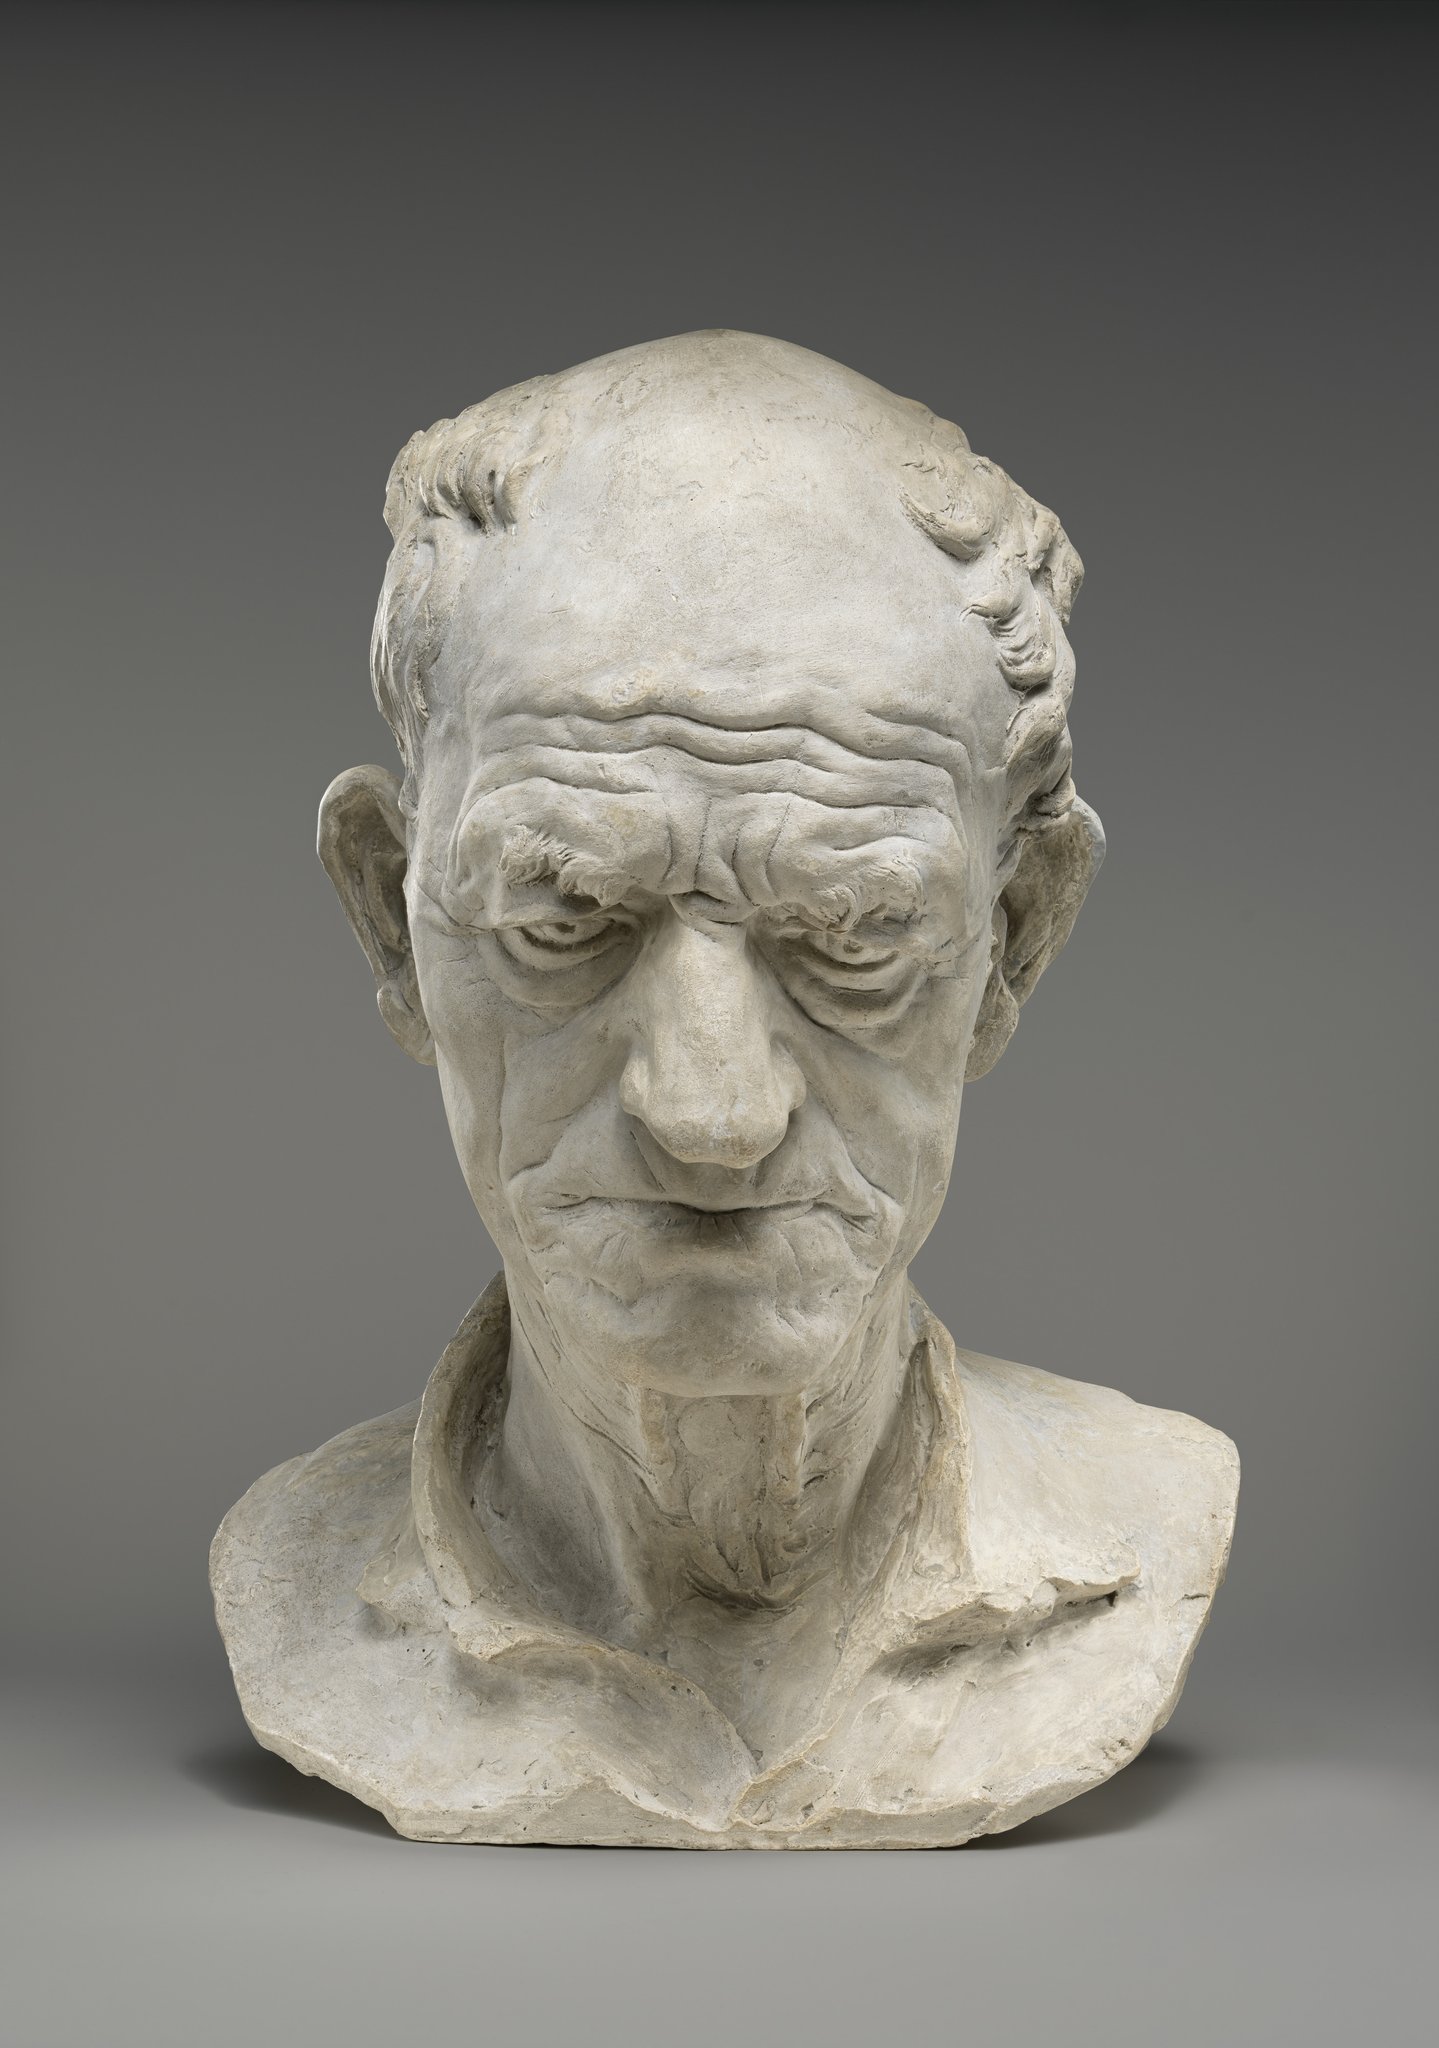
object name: bust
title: Head of a Peasant (Tête de paysan)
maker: aimé-jules dalou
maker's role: artist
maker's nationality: french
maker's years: 1838-1902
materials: plaster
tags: heads,men,portraits